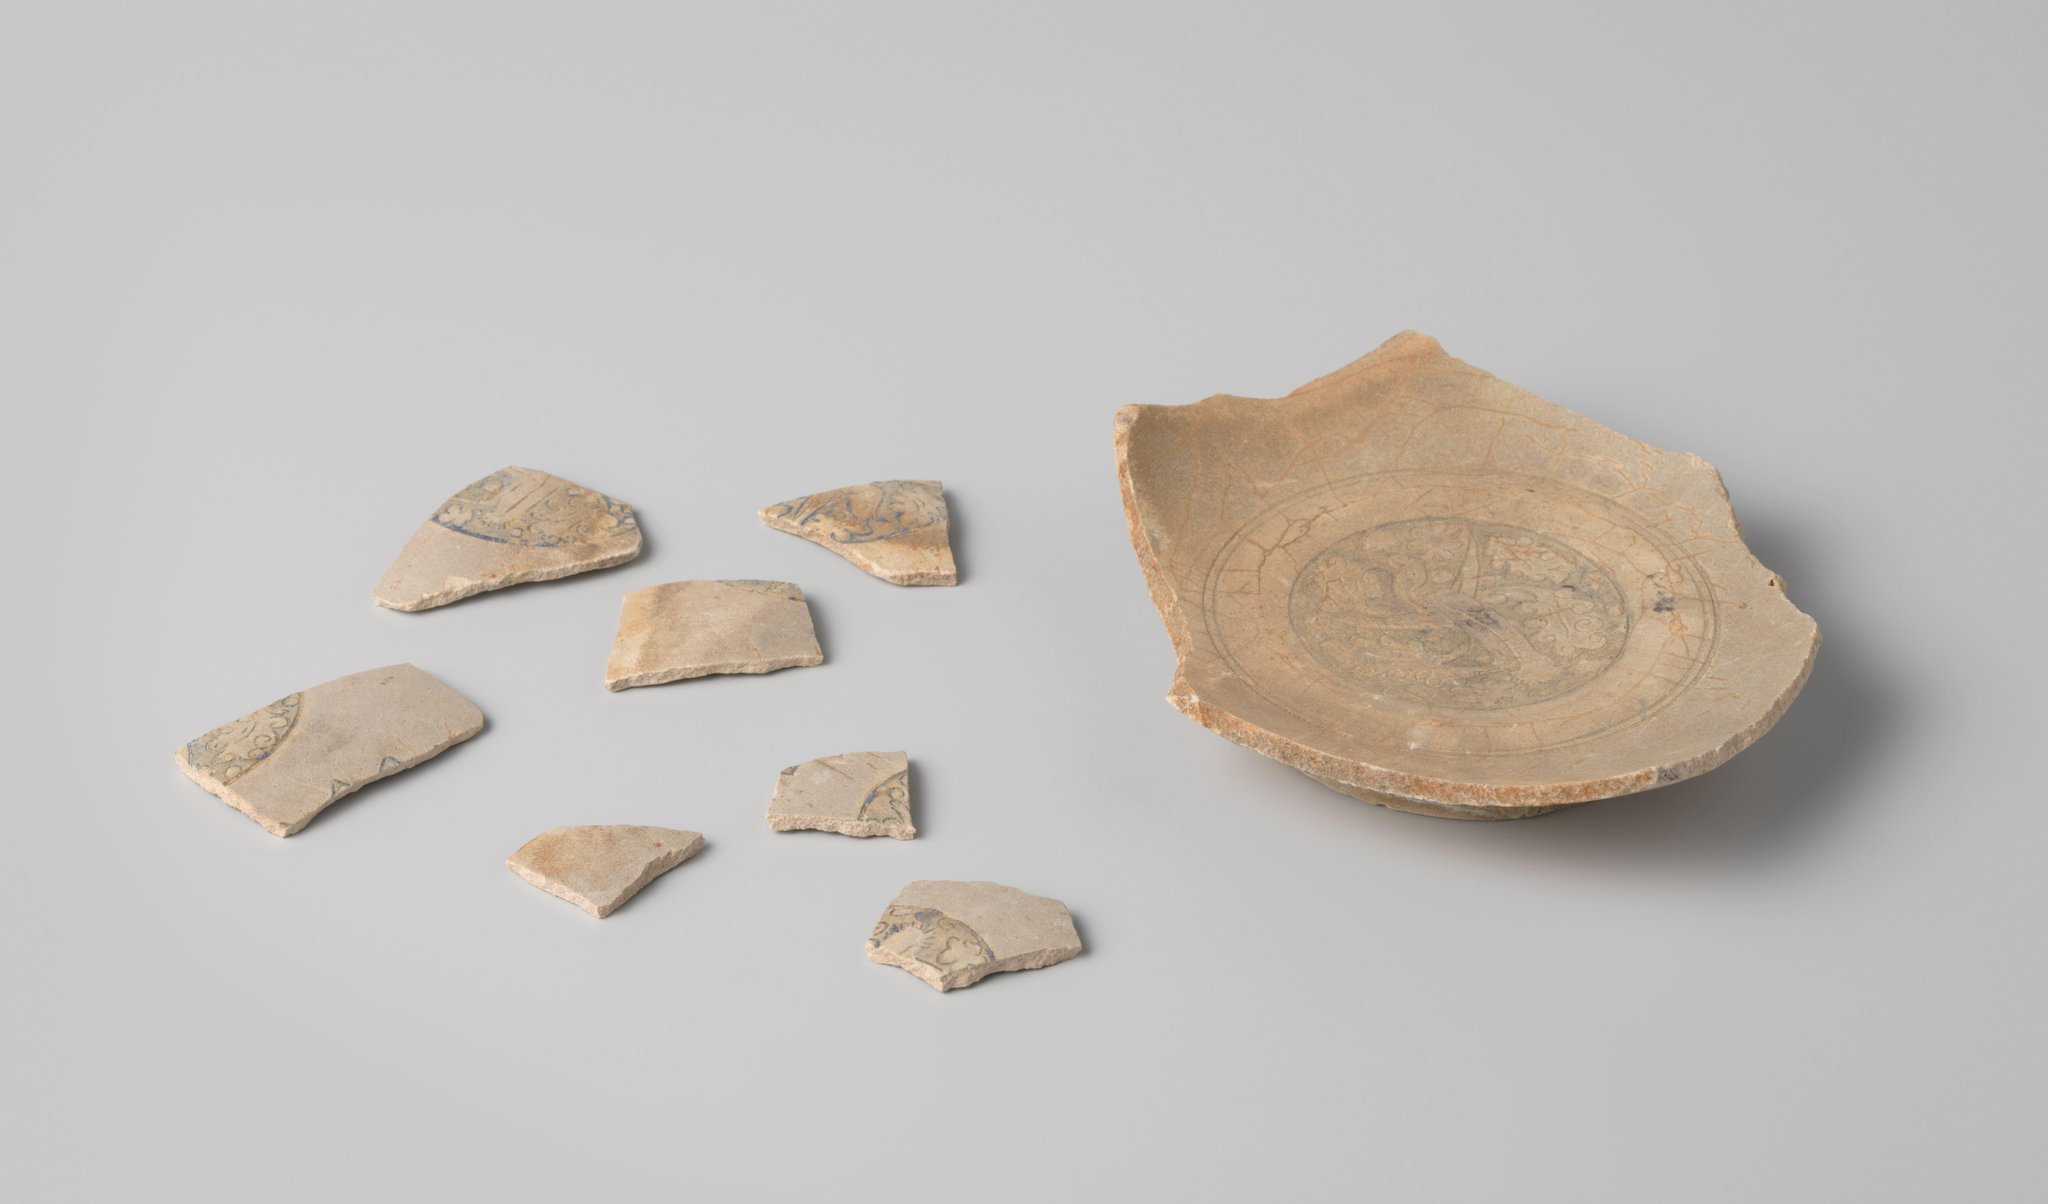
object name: bowl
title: Acht scherven van een kom uit V.O.C.-schip de 'Witte Leeuw'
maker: Anonymous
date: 1613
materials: earthenware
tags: verenigde oostindische compagnie, sint-helena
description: Acht scherven van een kom, bodem- en wandfragmenten, uit V.O.C.-schip de 'Witte Leeuw'.